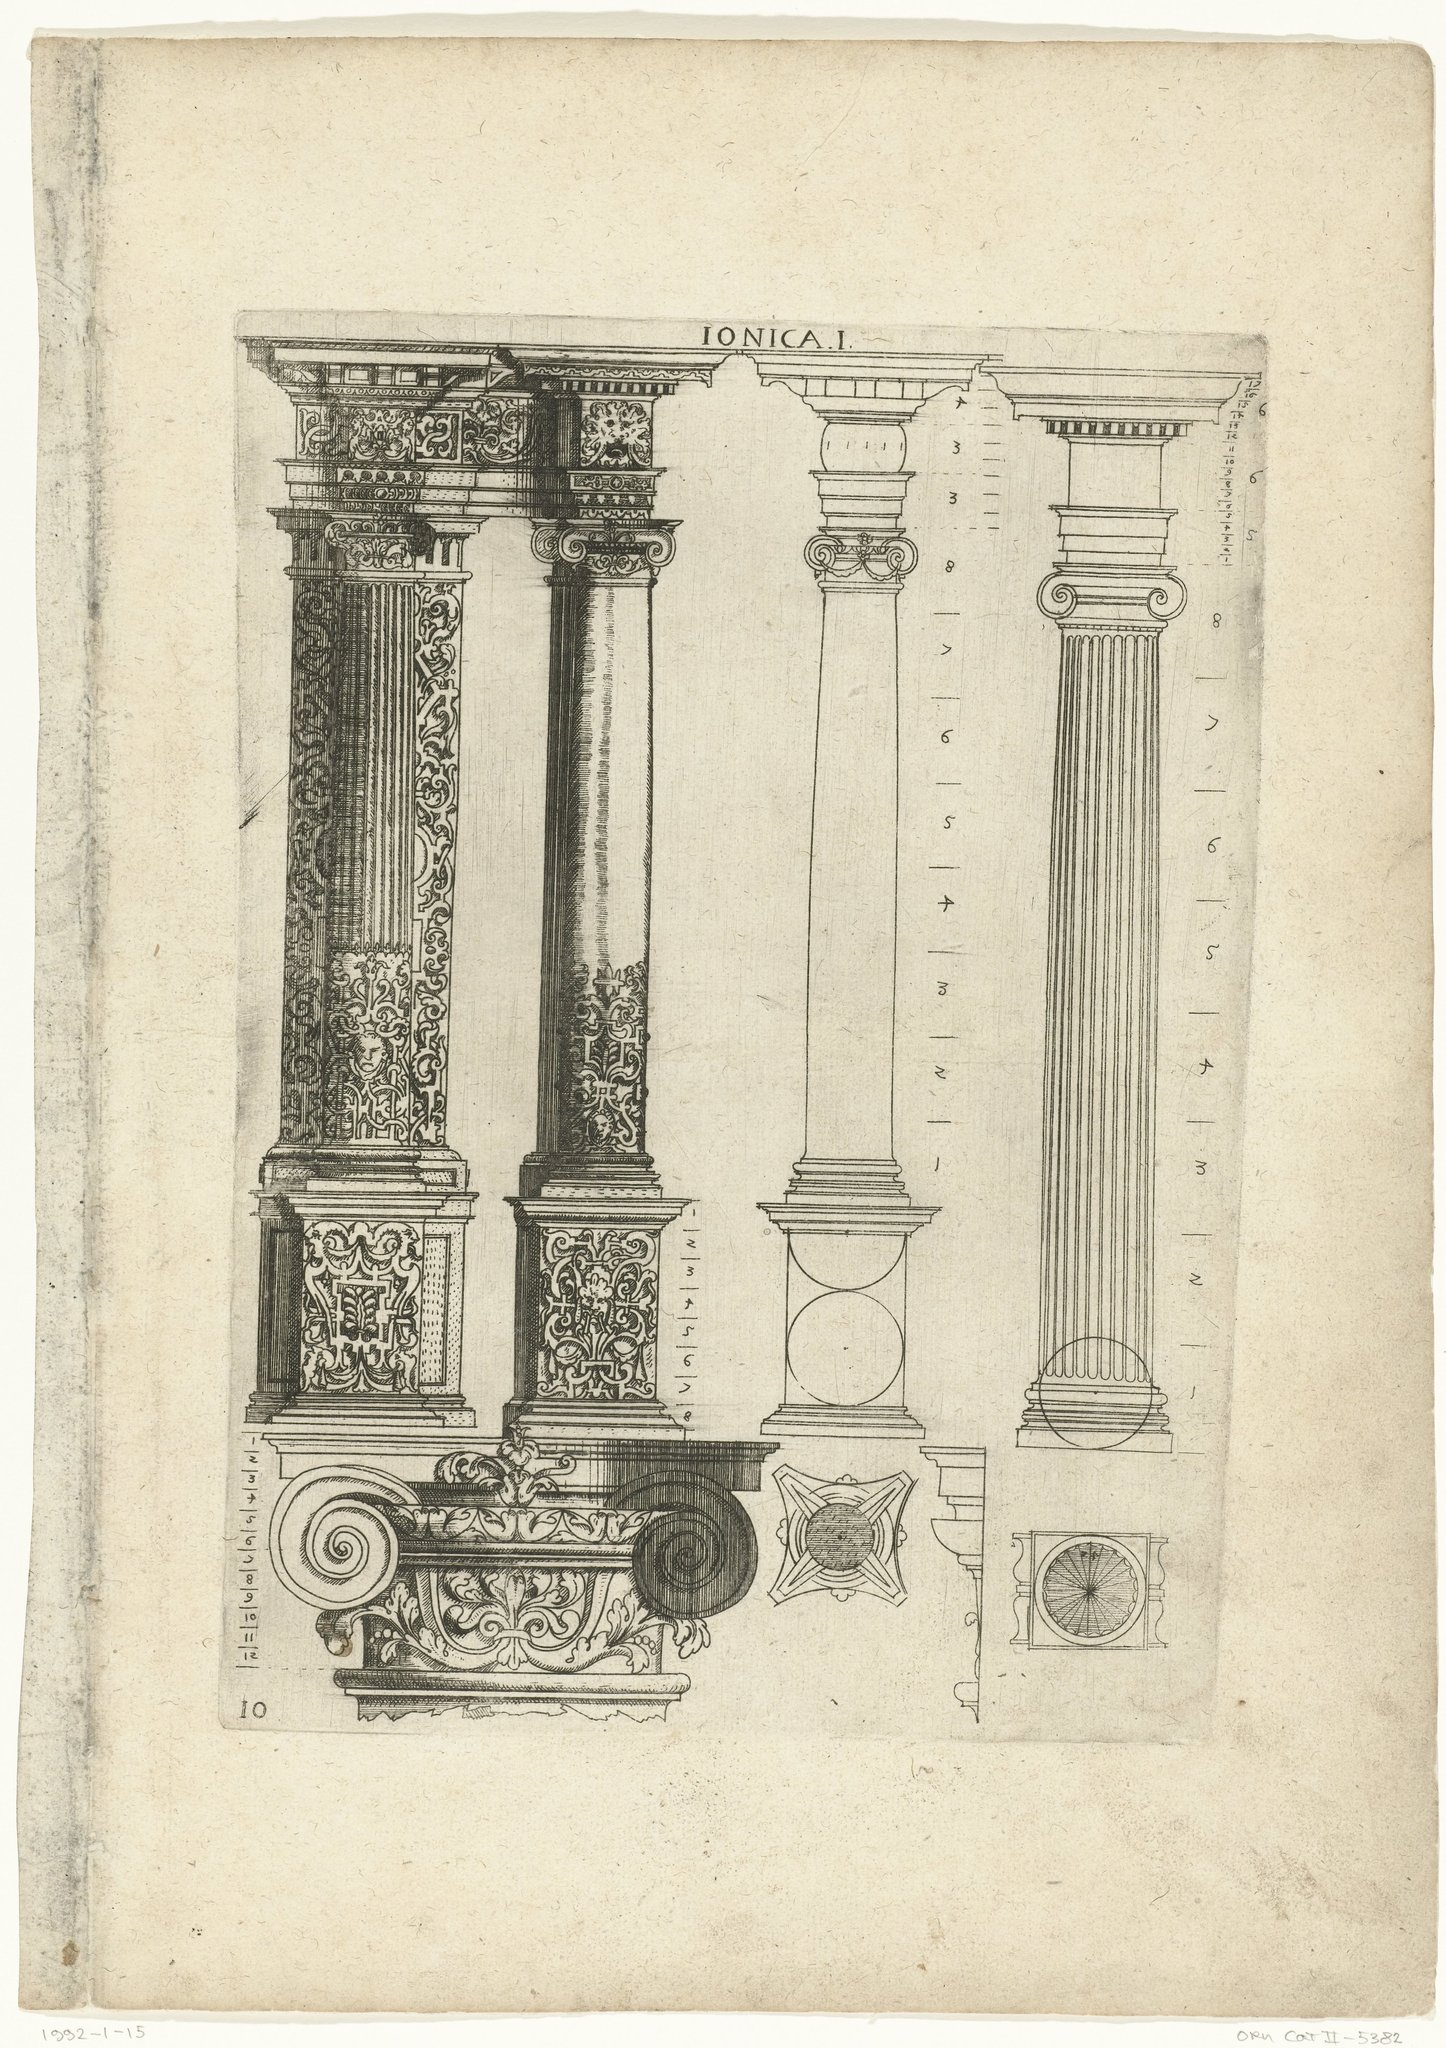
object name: ornament print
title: Architectura von den funf Seuvlen (...)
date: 1610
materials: paper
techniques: etching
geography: germany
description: Onderaan zijn te zien: een kapiteel, twee plannen voor kapitelen en een doorsnede van een pilasterkapiteel. Blad 10 uit serie van titelblad en 28 bladen.